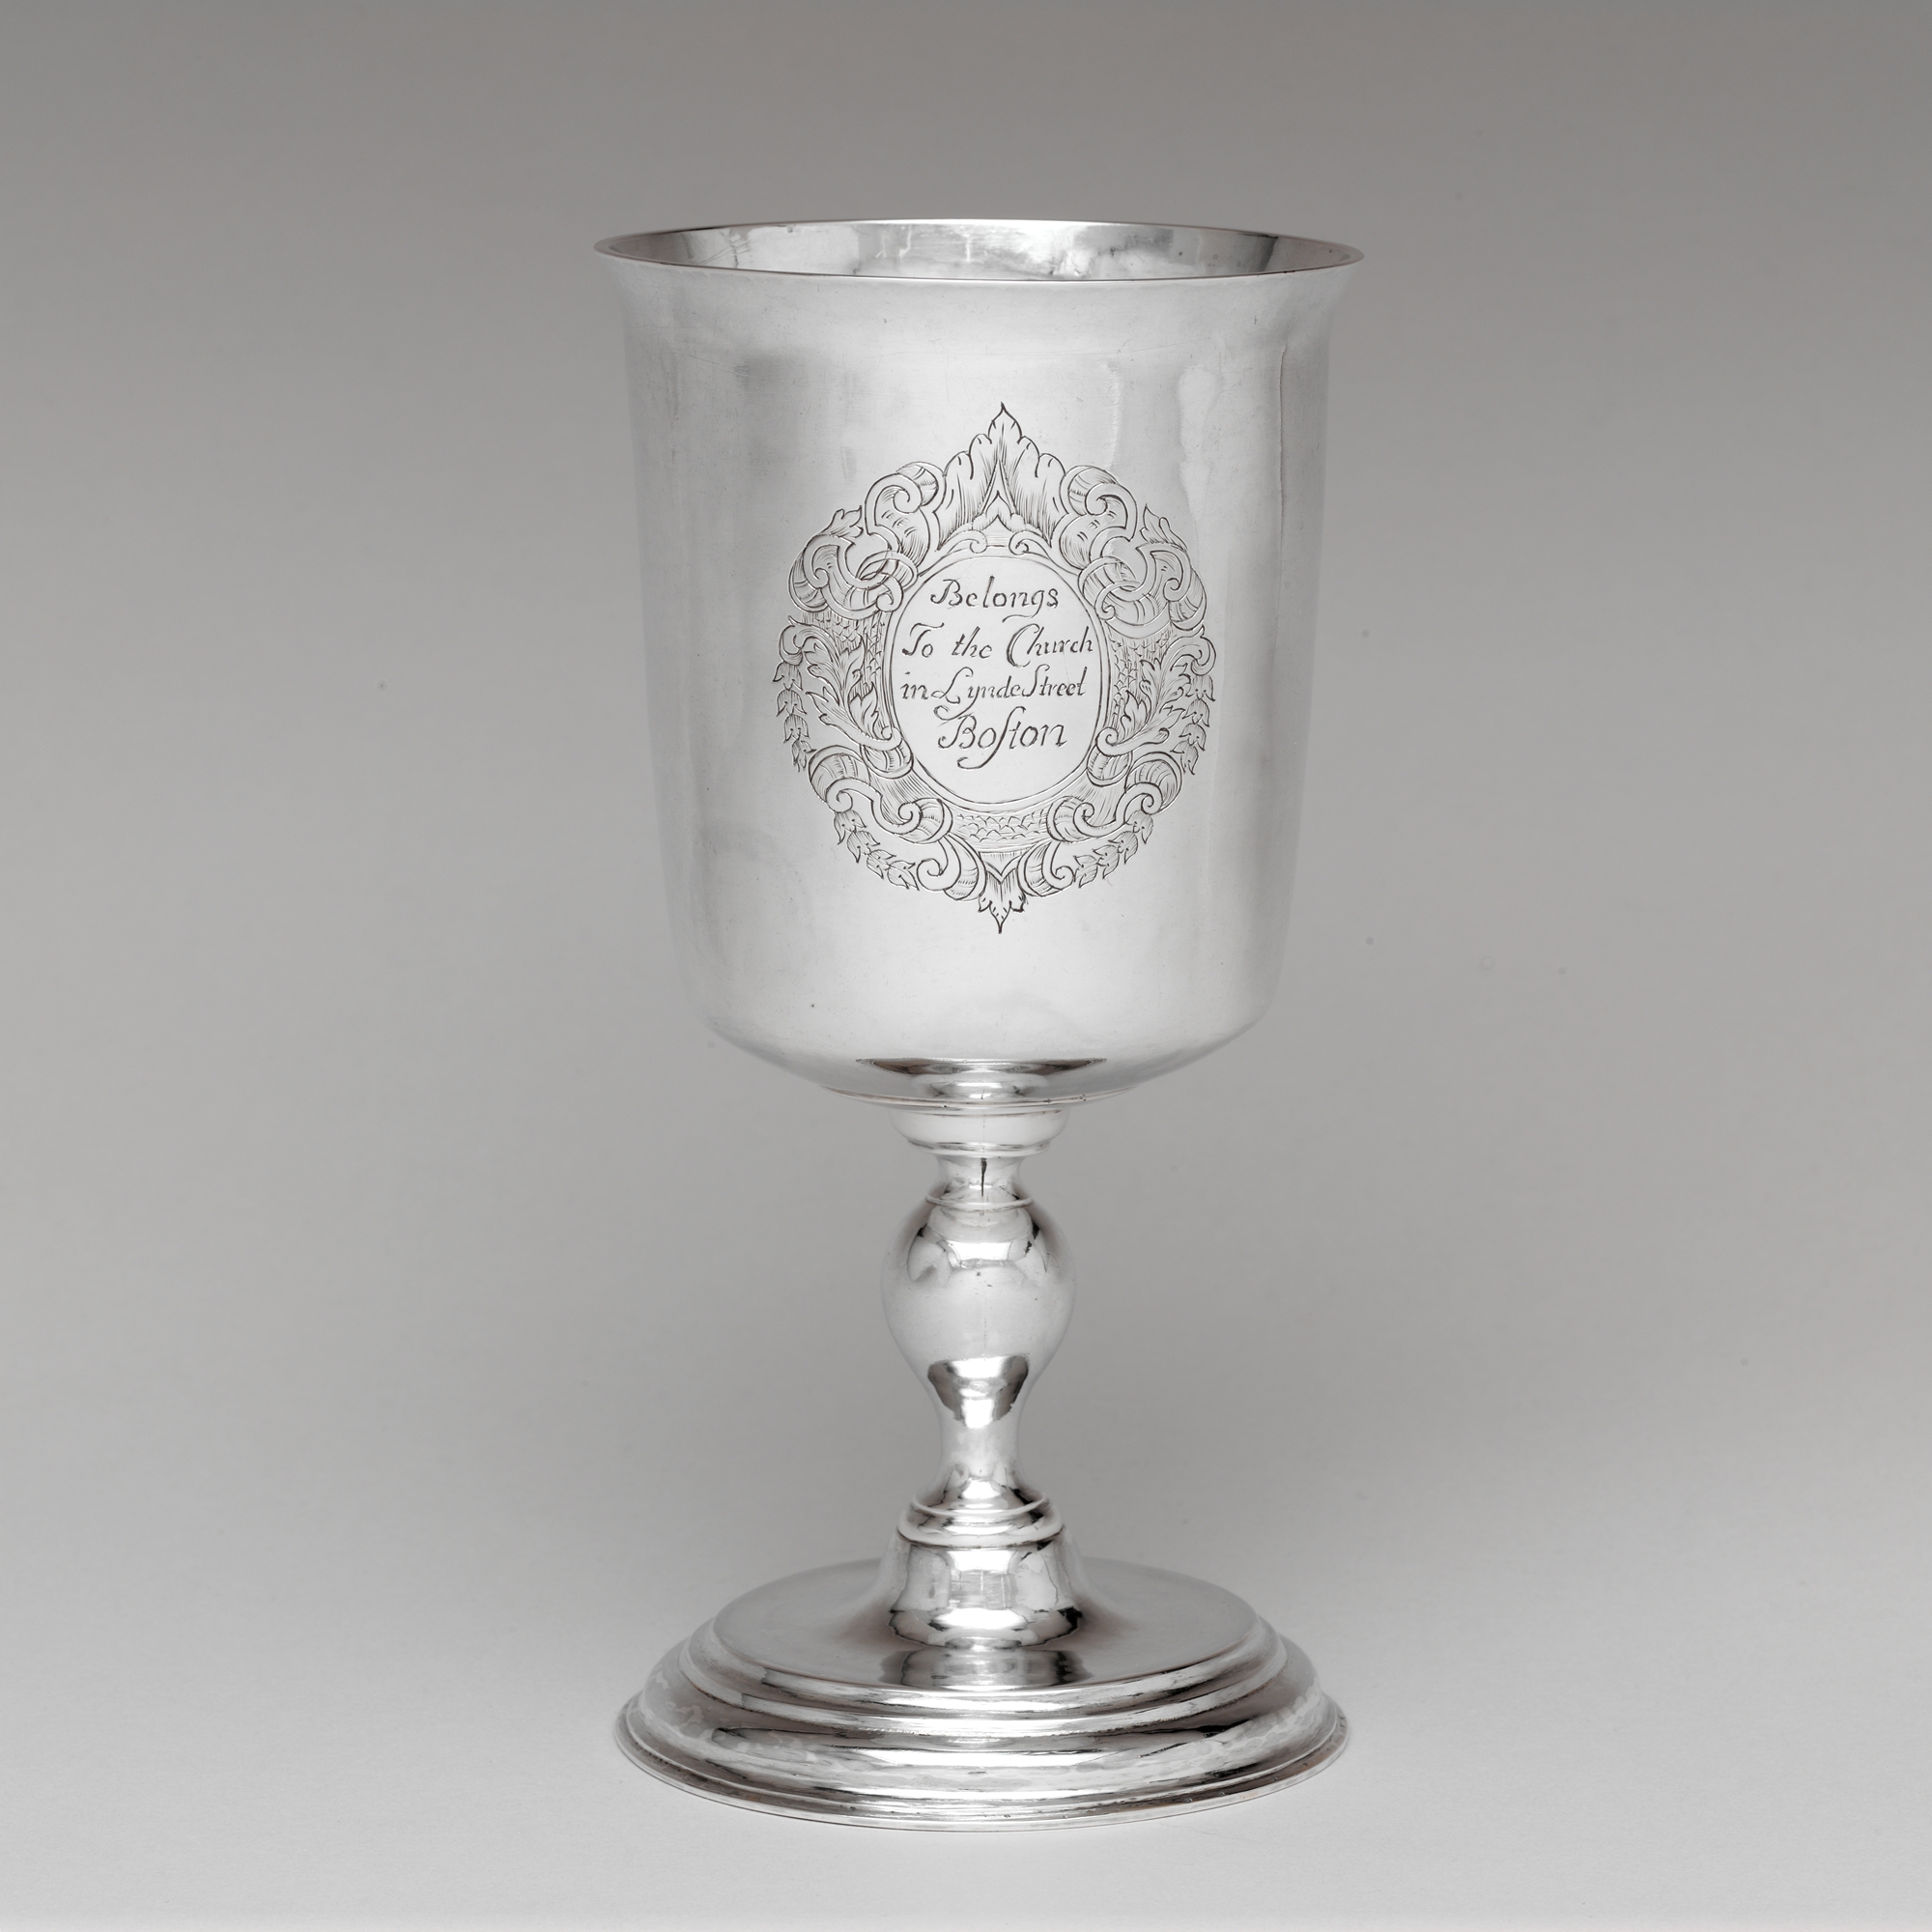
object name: cup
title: Wine Cup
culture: american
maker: samuel edwards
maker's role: maker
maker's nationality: american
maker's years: 1705-1762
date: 1740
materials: silver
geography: united states